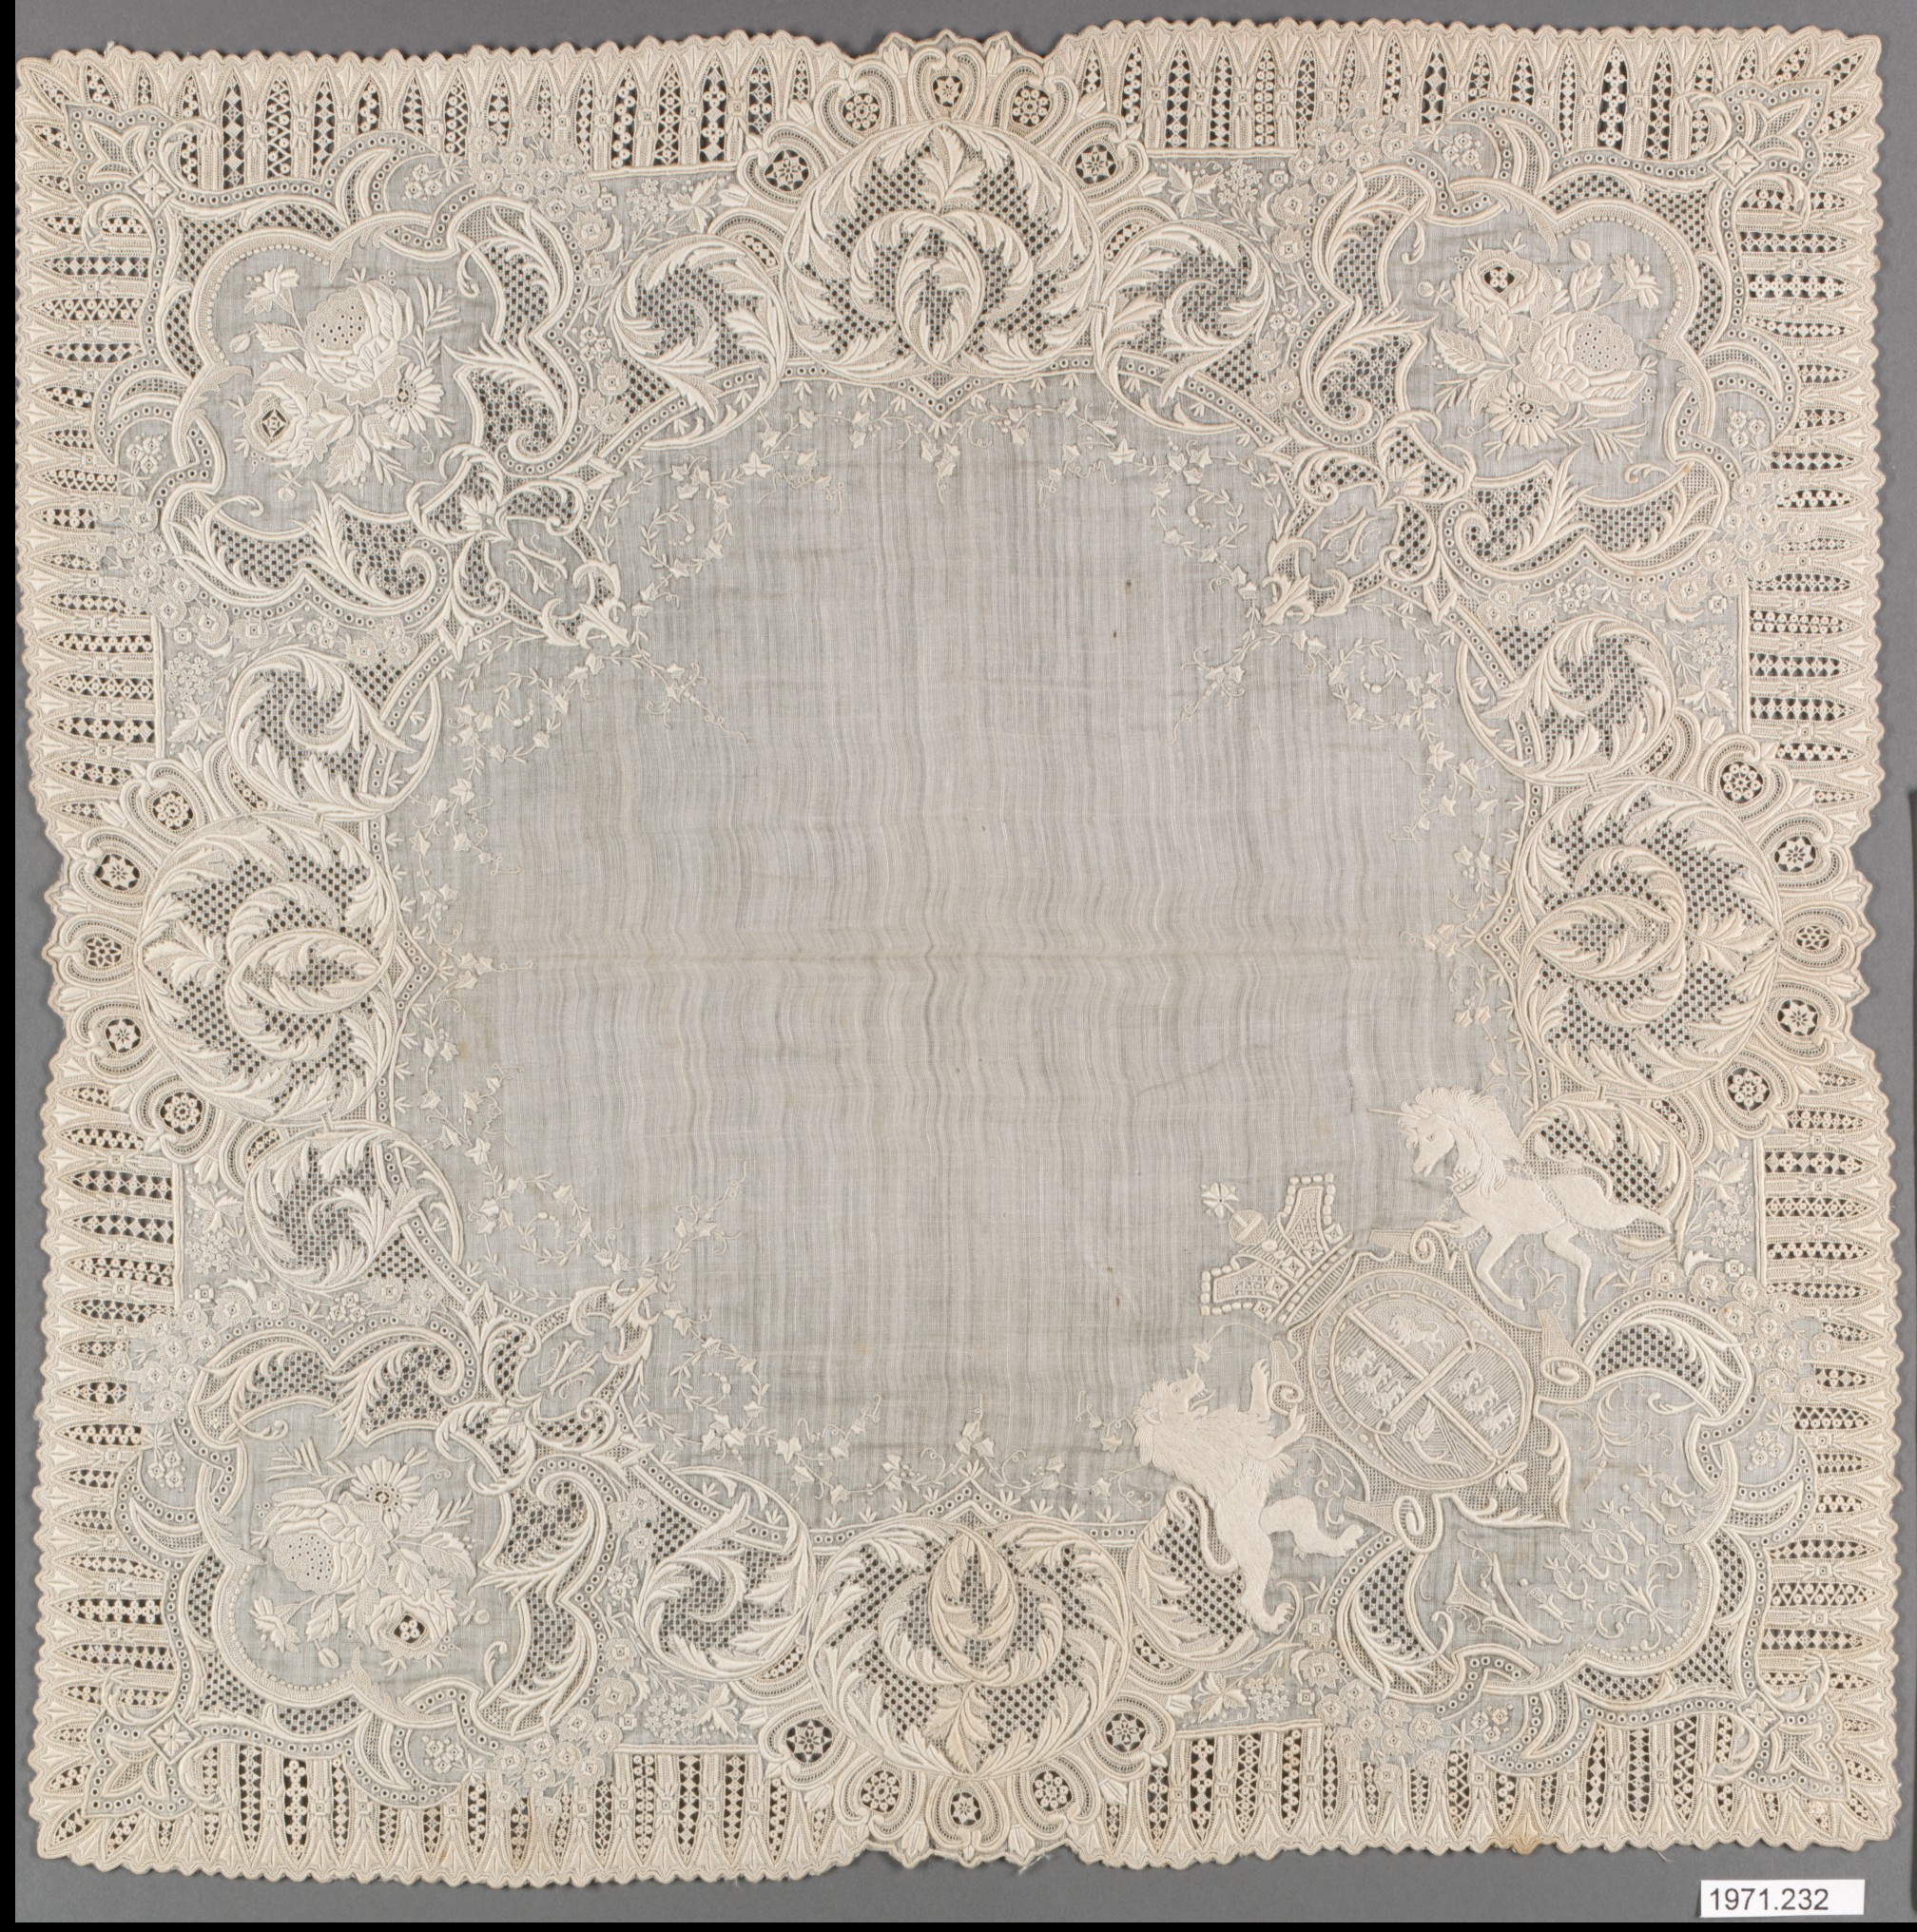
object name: handkerchief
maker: j.j. nef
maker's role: manufactory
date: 1850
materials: cotton, linen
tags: unicorns,lions,flowers,coat of arms